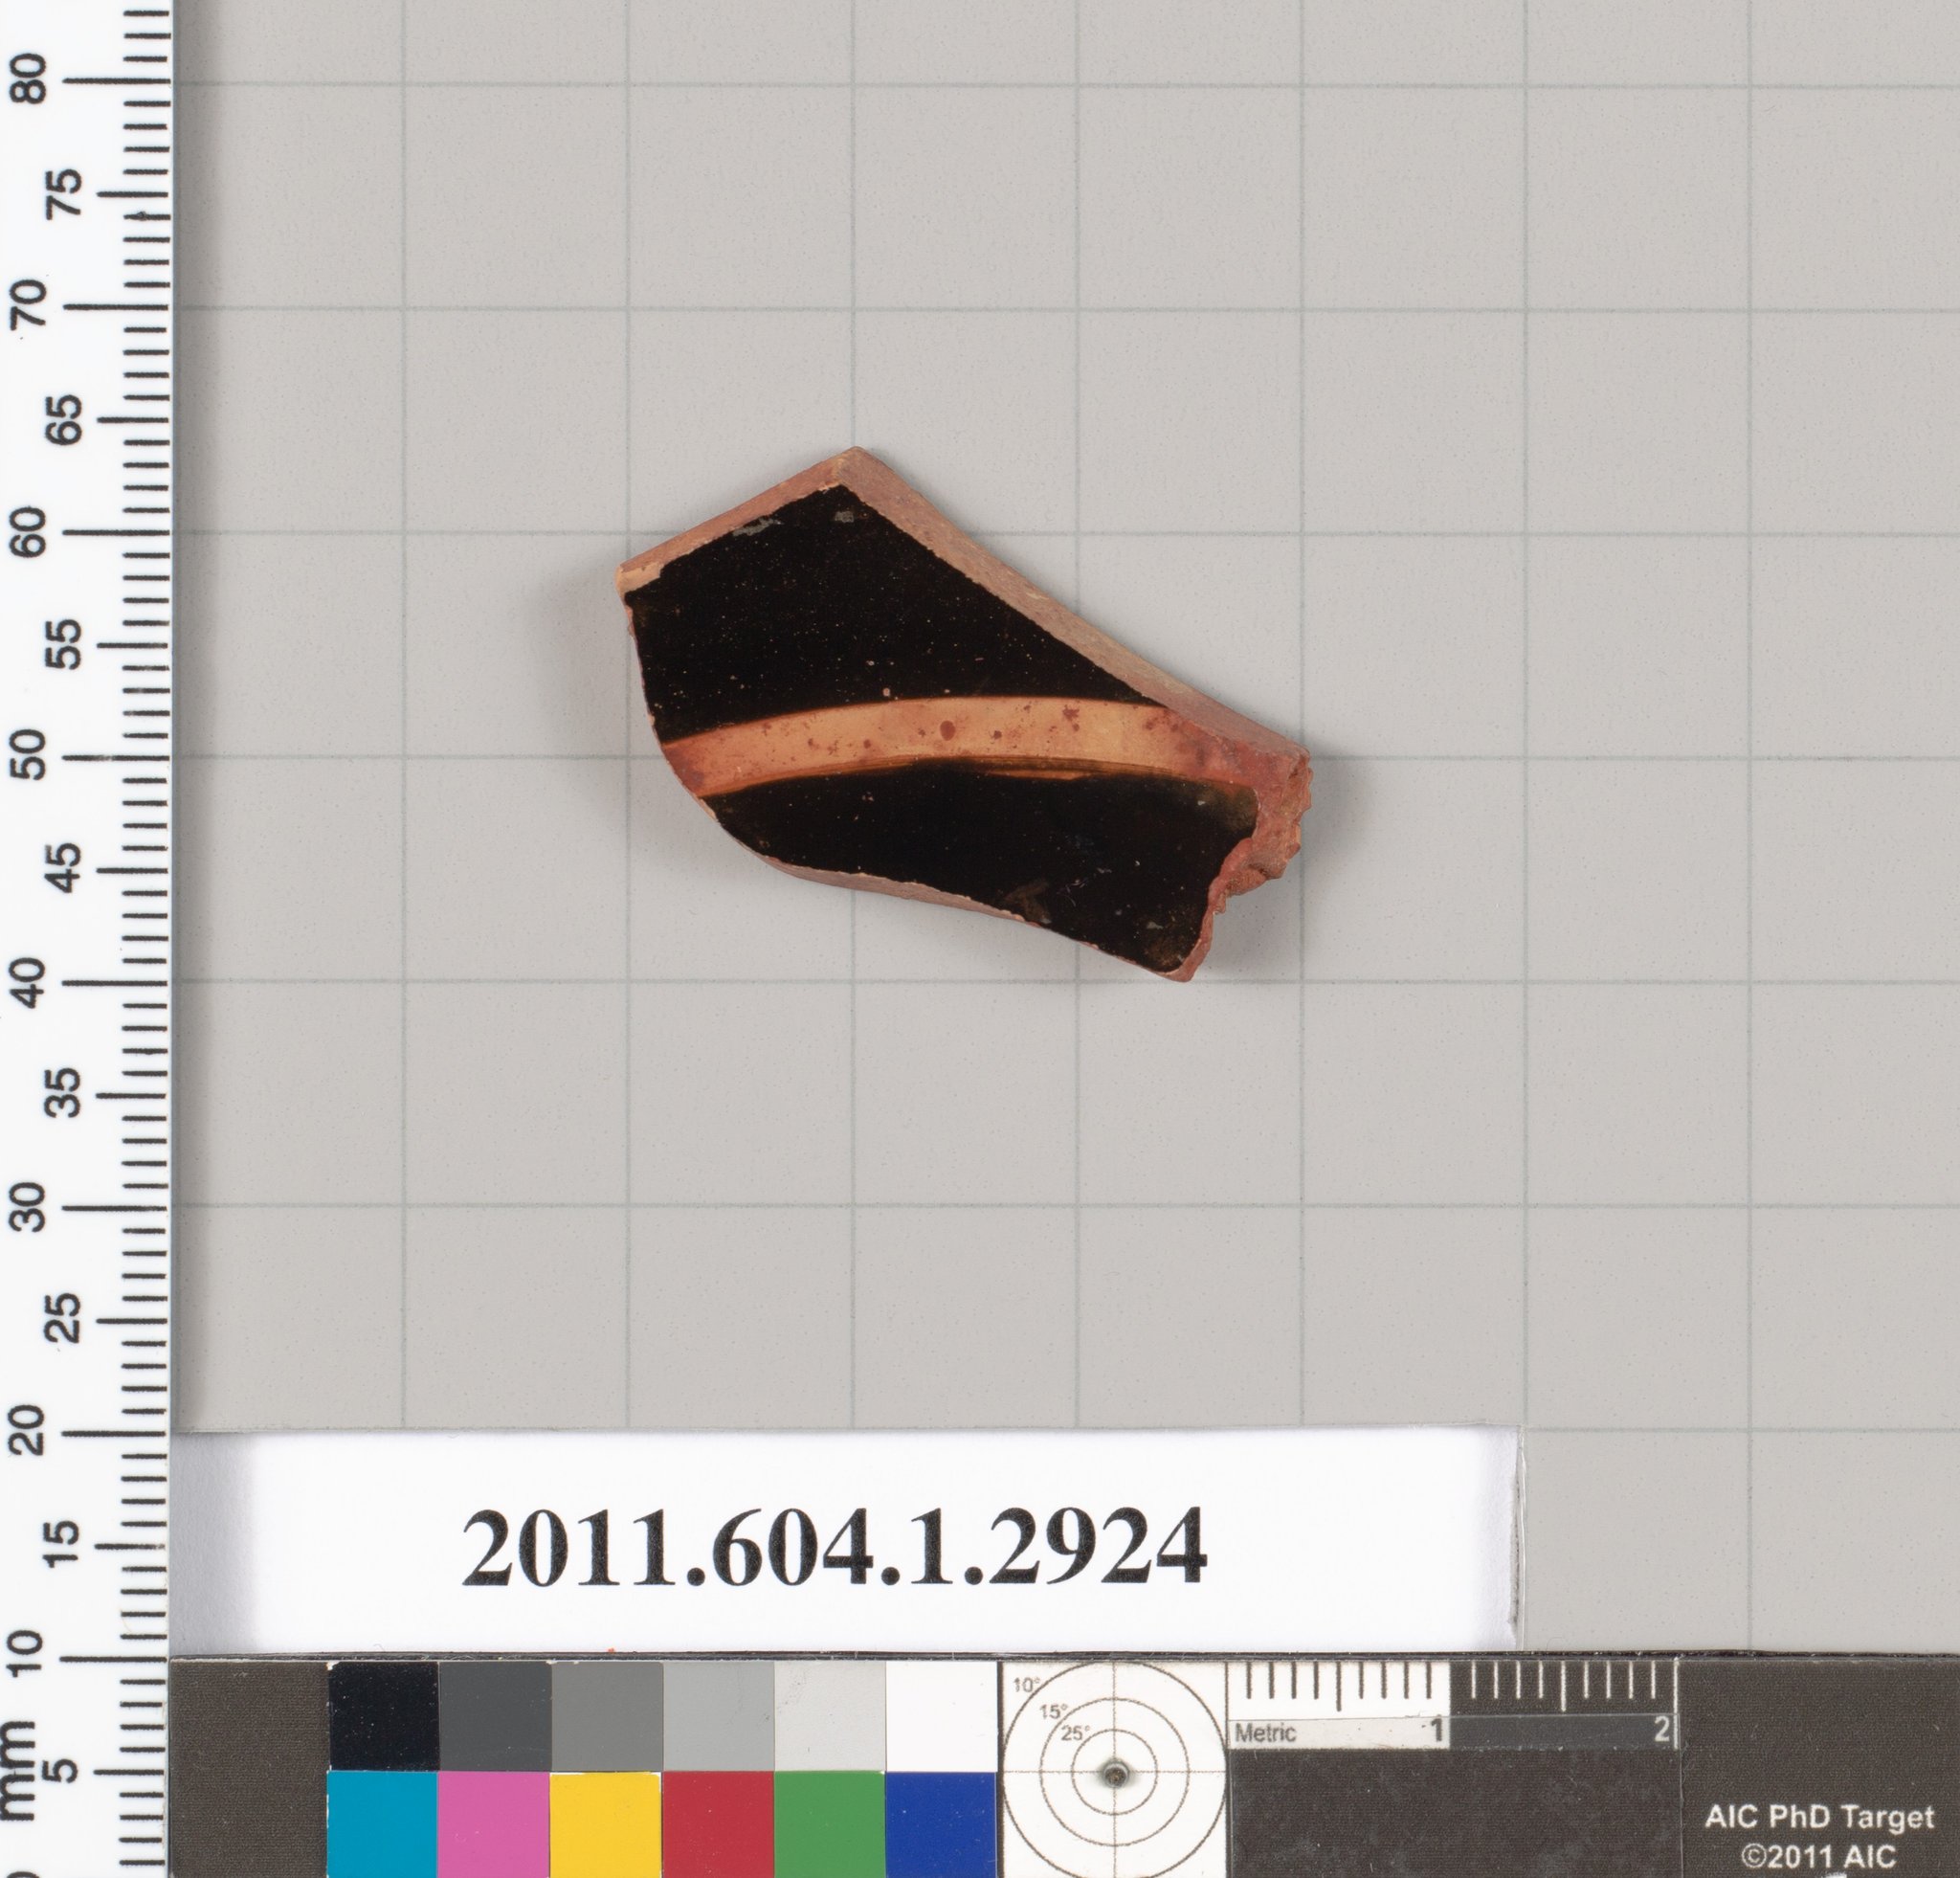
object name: kylix fragment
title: Terracotta fragment of a kylix (drinking cup)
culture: greek, attic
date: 600-401 BCE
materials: terracotta